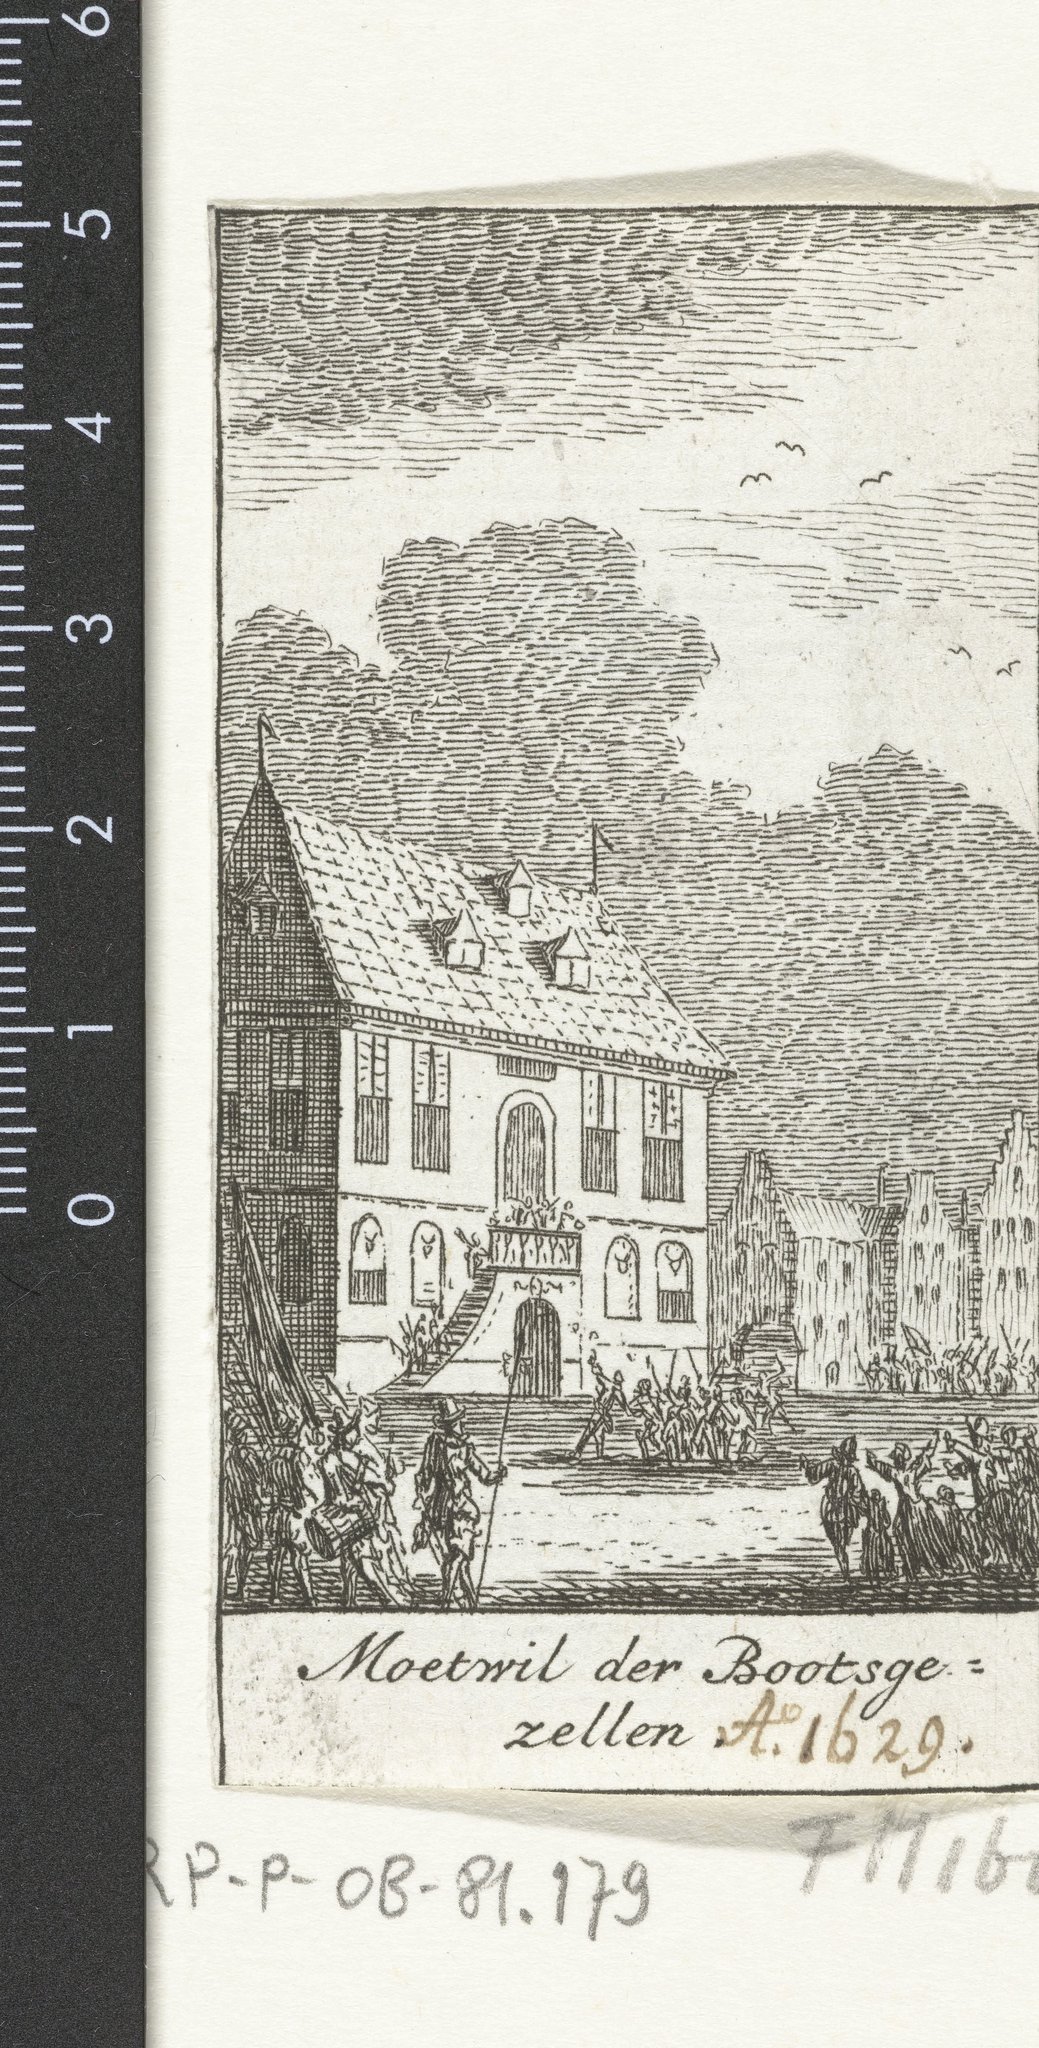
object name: print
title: Moetwil der Bootsgezellen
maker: simon fokke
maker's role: draughtsman, print maker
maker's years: 1712-1784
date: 1722-1784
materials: paper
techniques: etching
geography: northern netherlands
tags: street-fights, riots, amsterdam, capture of the spanish treasure fleet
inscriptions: inscription: ‘Ao. 1629’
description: Relletjes door opstandige scheepsbemanning te Amsterdam, wegens het onthouden van hun aandeel in de buit van de Zilvervloot, januari 1629